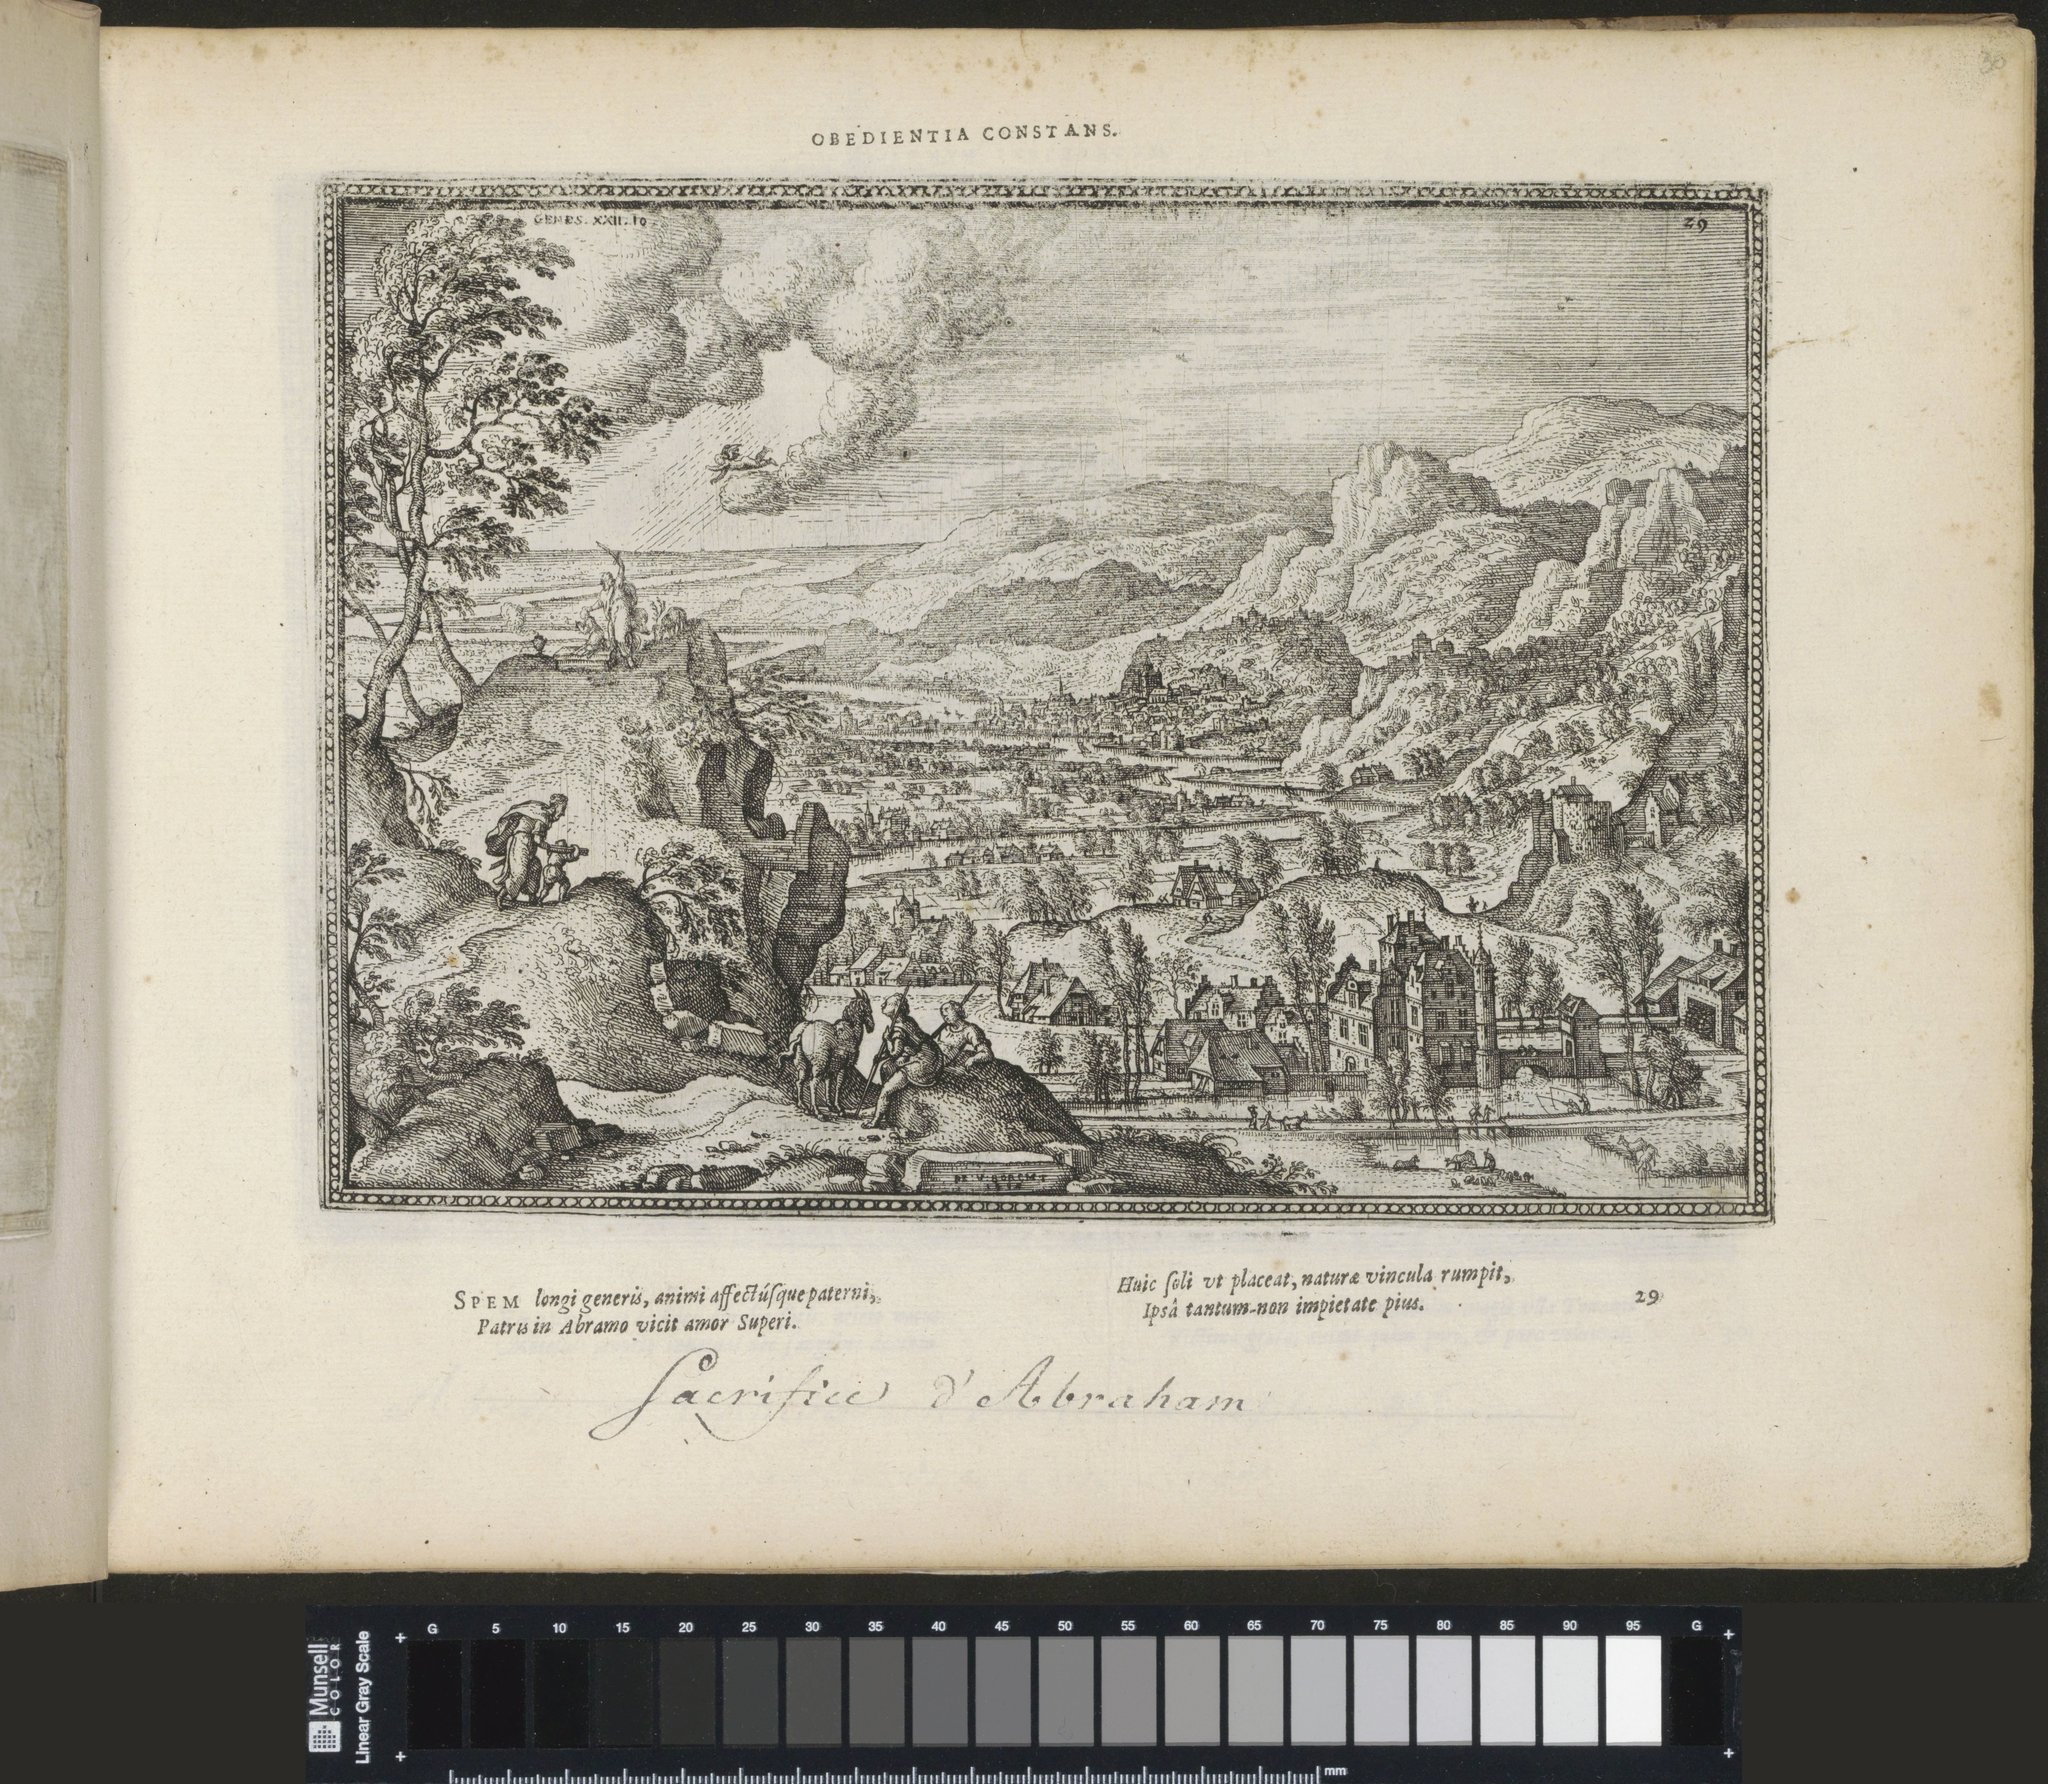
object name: print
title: Emblemata Sacra è praecipuis utriusque testamenti historiis concinnata (Oude Testament)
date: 1582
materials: paper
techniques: etching, letterpress printing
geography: antwerp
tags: city-view, and landscape with man-made constructions, dale, valley - hh - ideal landscapes, the sacrifice of isaac (genesis 22), river, when abraham has his hand raised to kill isaac, god or the hand of god restrains abraham's hand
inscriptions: inscription: ‘Sacrifice d'Abraham’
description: Landschap met een rivier in een vallei. Links zijn Abraham en Isaak op de berg waar Isaak geofferd moet worden. Isaak draagt het hout voor het altaarvuur. Bovenop de berg heft Abraham zijn mes om zijn zoon offeren, maar een engel weerhoudt hem daarvan. Naast Abraham staat de ram die in plaats van Isaak geofferd wordt (Gen. 22:10). Onderaan de berg kijken twee mannen met herdersstokken toe. Met een motto in het Latijn boven de voorstelling en een vierregelig onderschrift in het Latijn onder de prent. De prent maakt deel uit van een album.